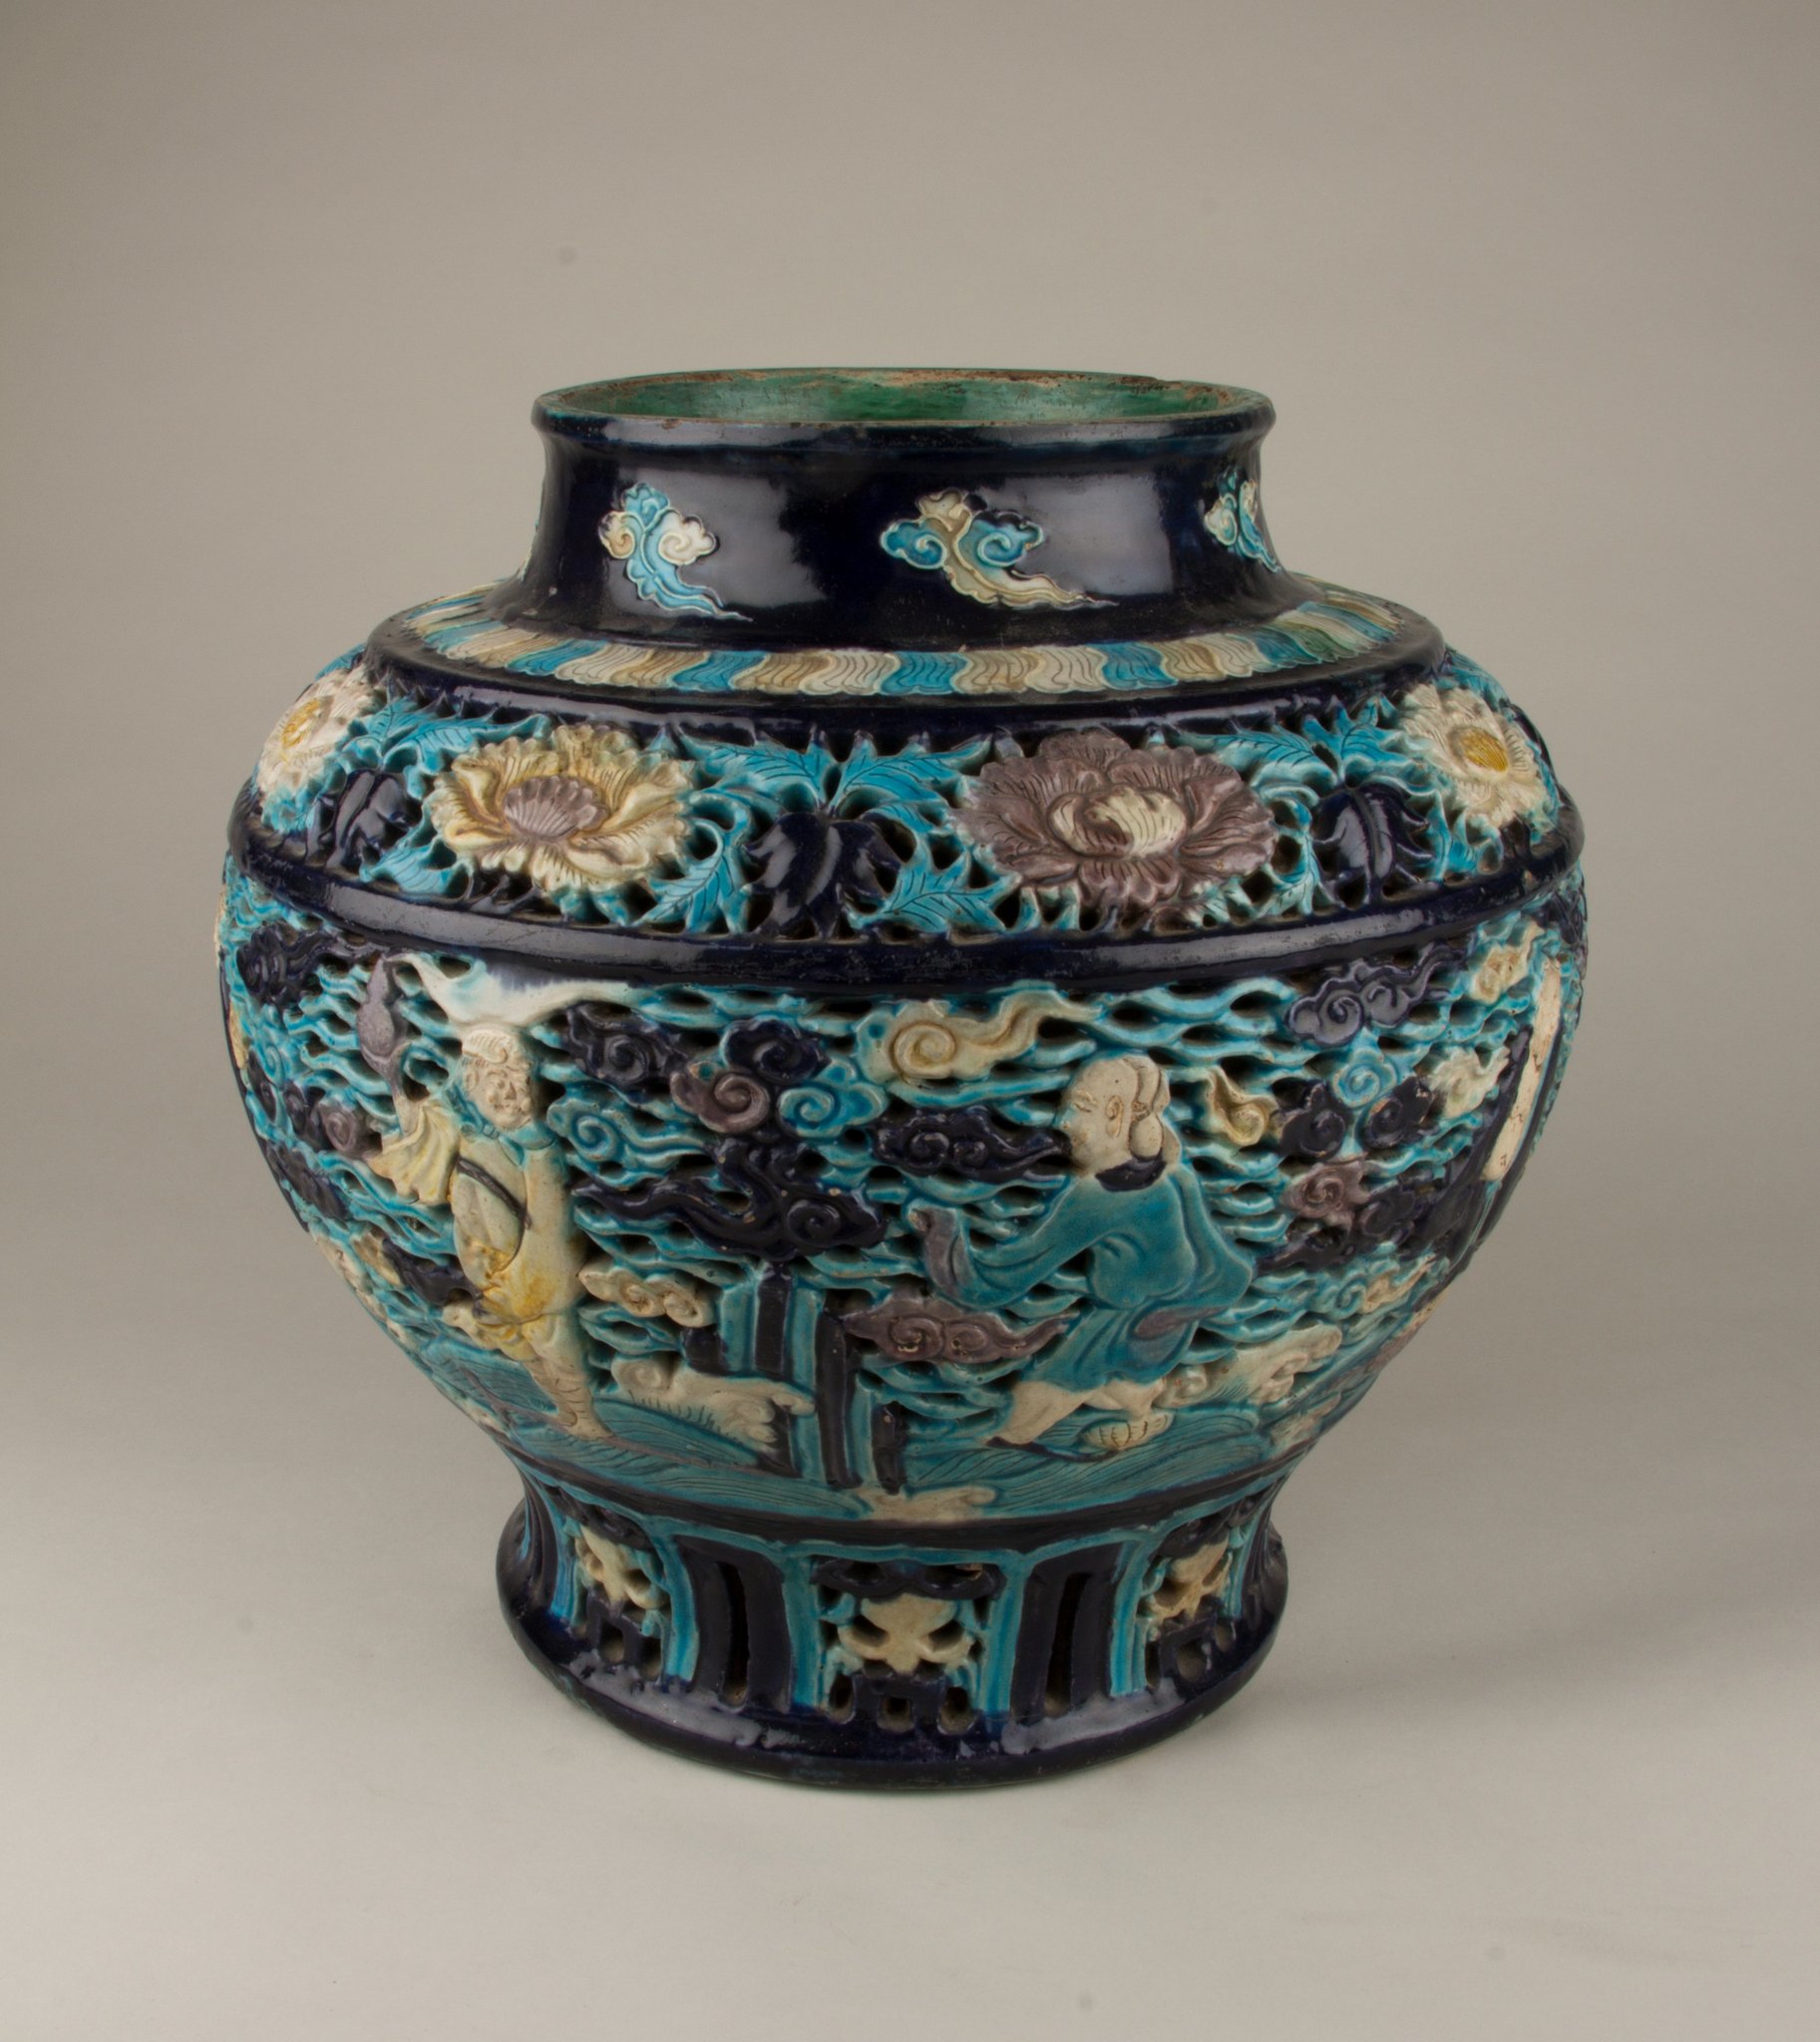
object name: jar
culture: chinese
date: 1368-1644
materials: pottery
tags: men,flowers